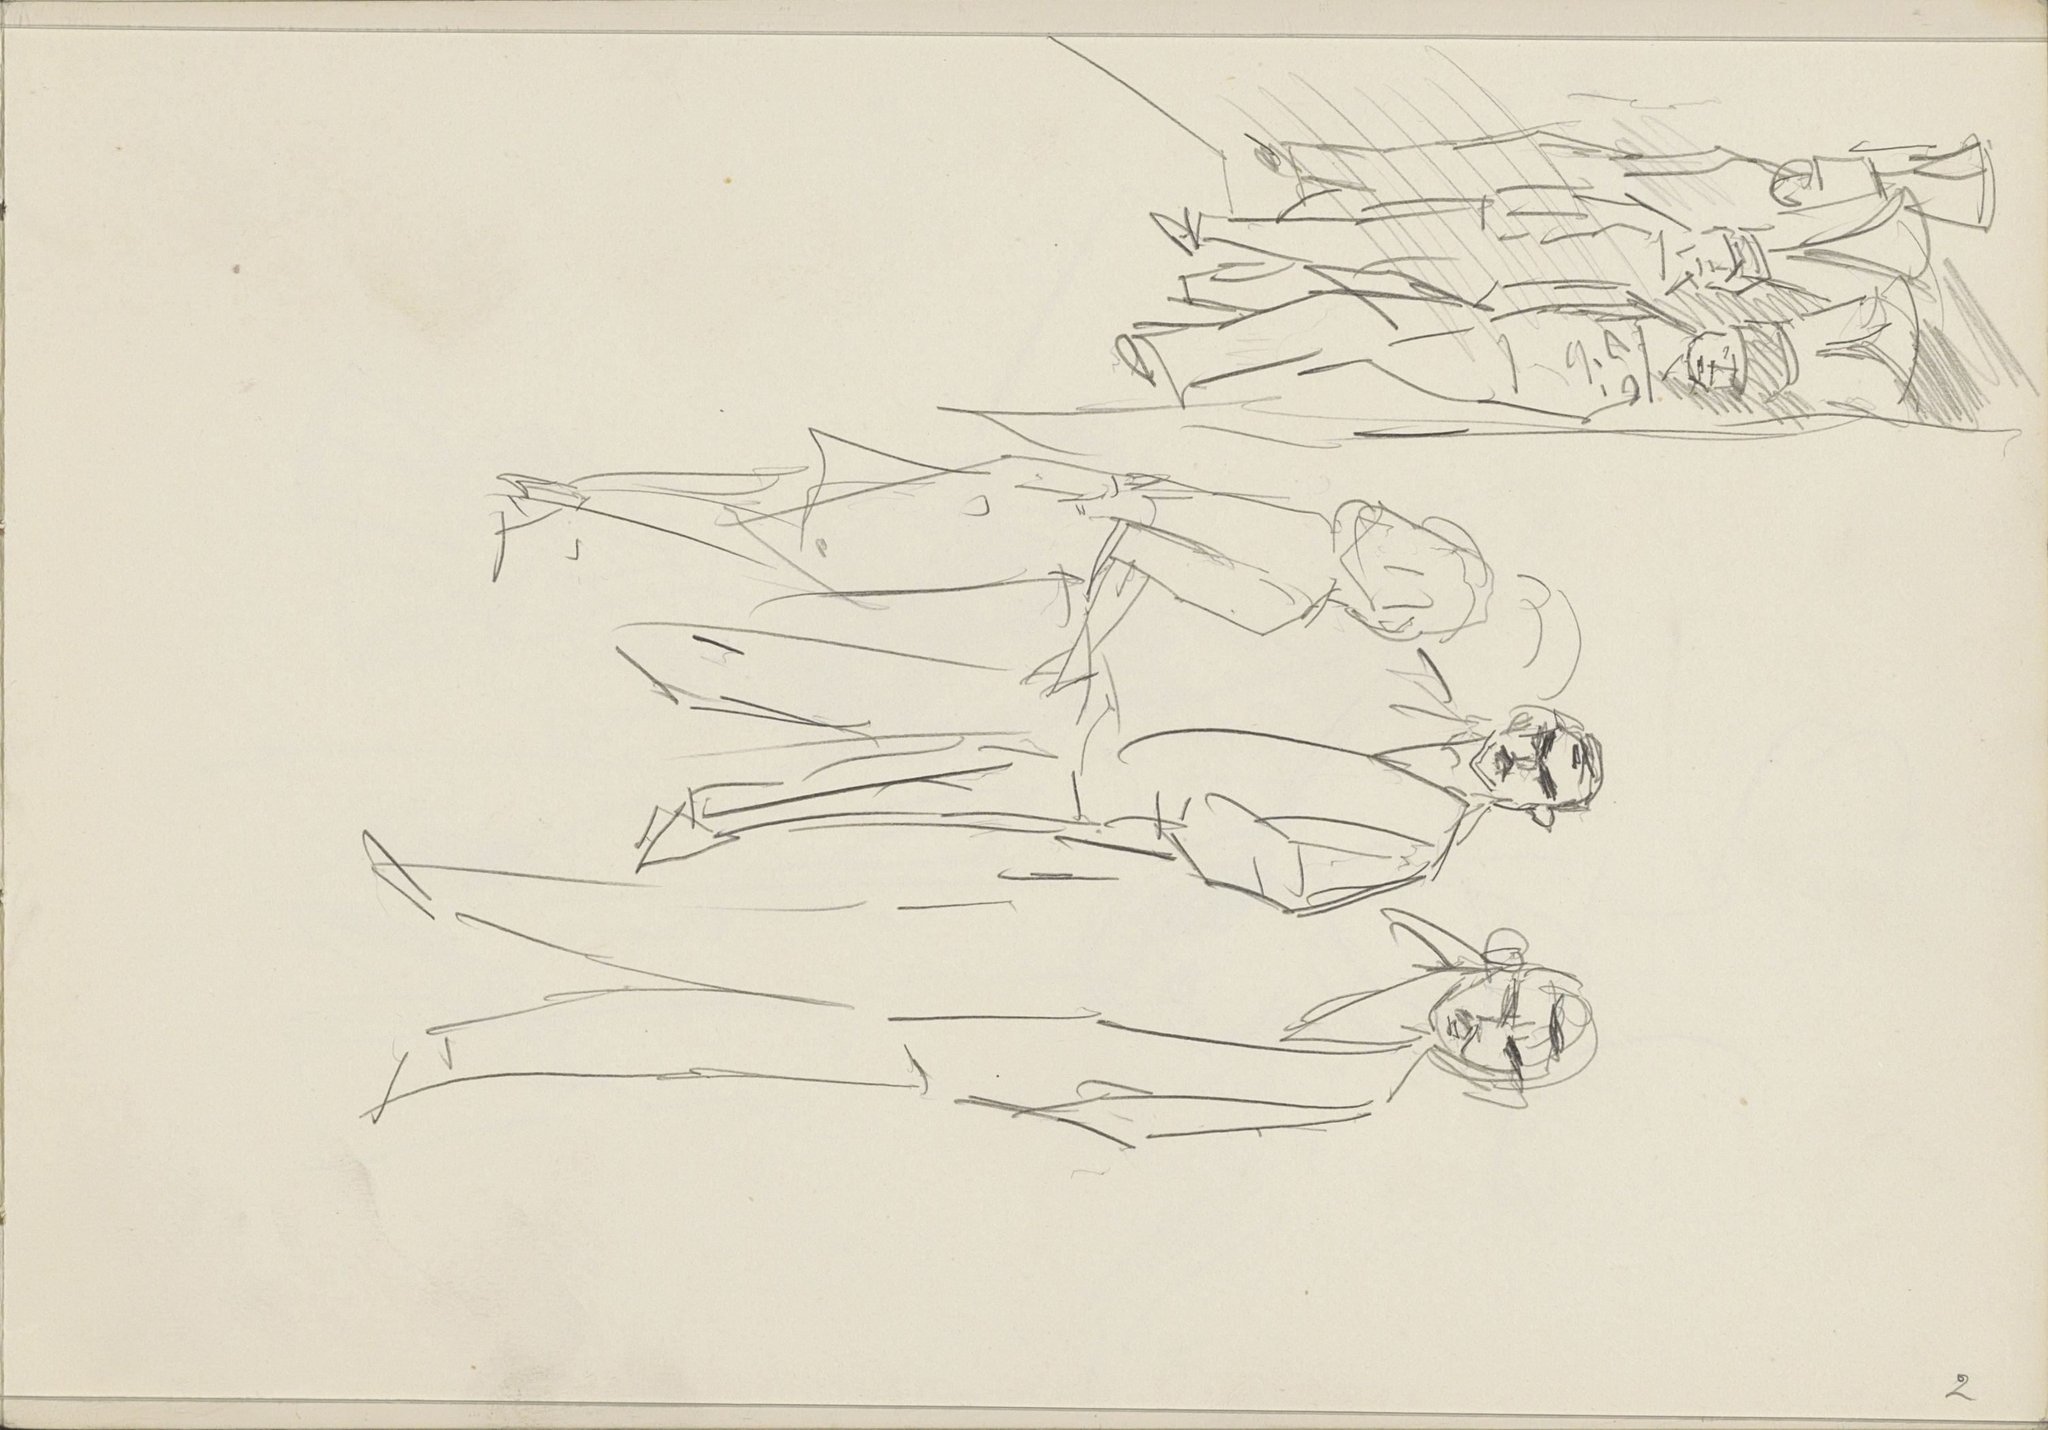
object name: sketchbook leaf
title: Staande figuren, mogelijk acteurs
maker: isaac israels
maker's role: draughtsman, painter, print maker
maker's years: 1865-1934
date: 1915-1934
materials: paper, pencil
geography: the hague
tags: stage costume, adult woman (+ standing), adult man (+ standing), actor (on the stage)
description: Deels verkleed. Blad 2 recto uit schetsboek XXV met 23 bladen.